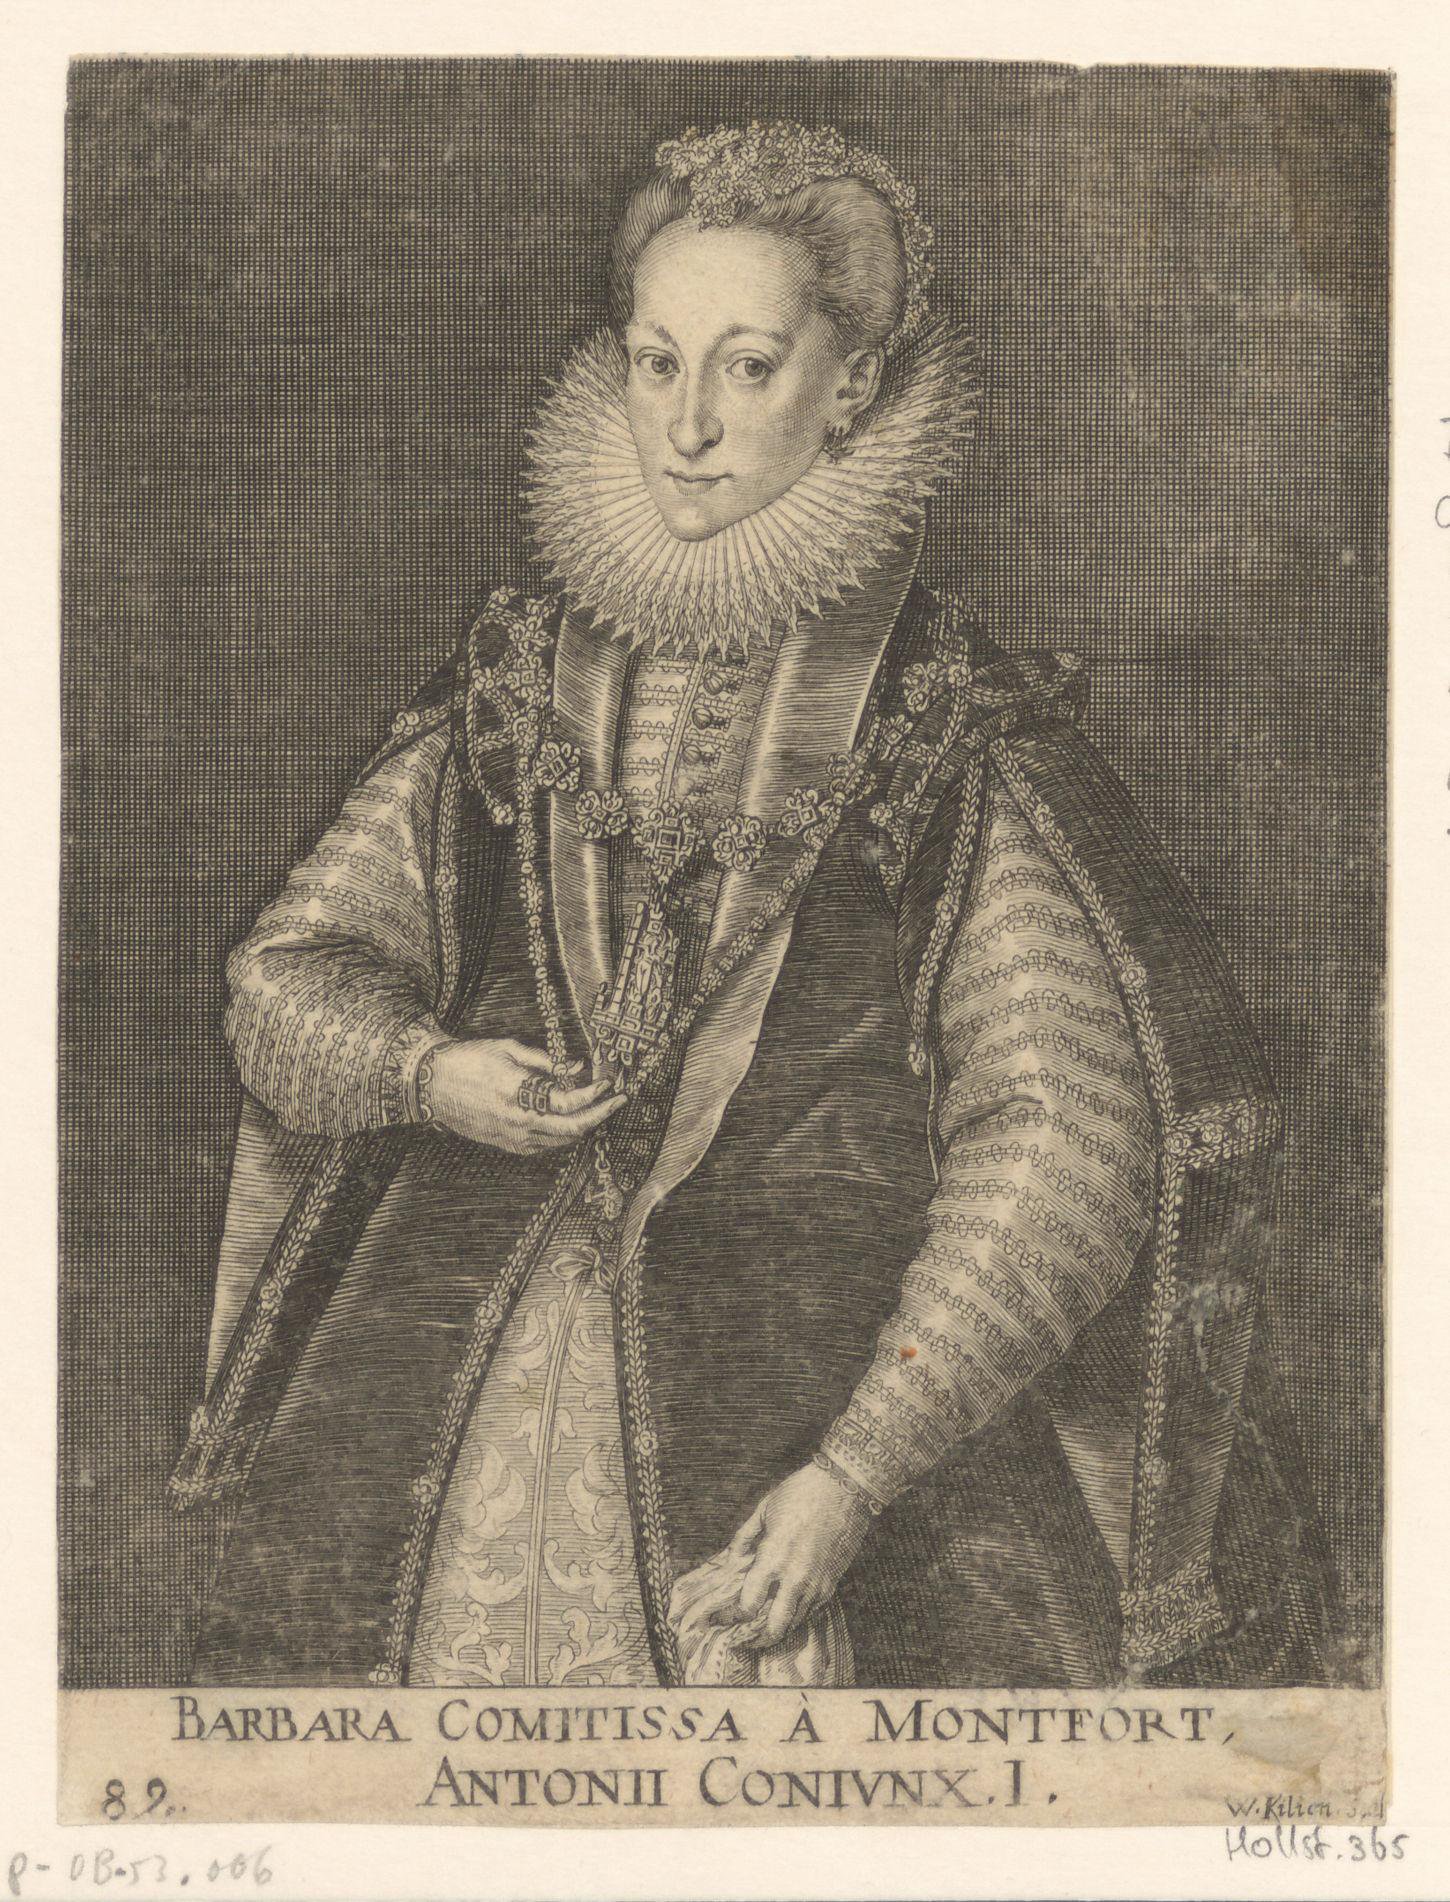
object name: print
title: Portret van Barbara Fugger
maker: wolfgang kilian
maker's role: print maker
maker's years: 1581-1662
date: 1591-1662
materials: paper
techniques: engraving, etching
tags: barbara fugger (gravin van montfort), historical persons, regent, substitute ruler; viceroy